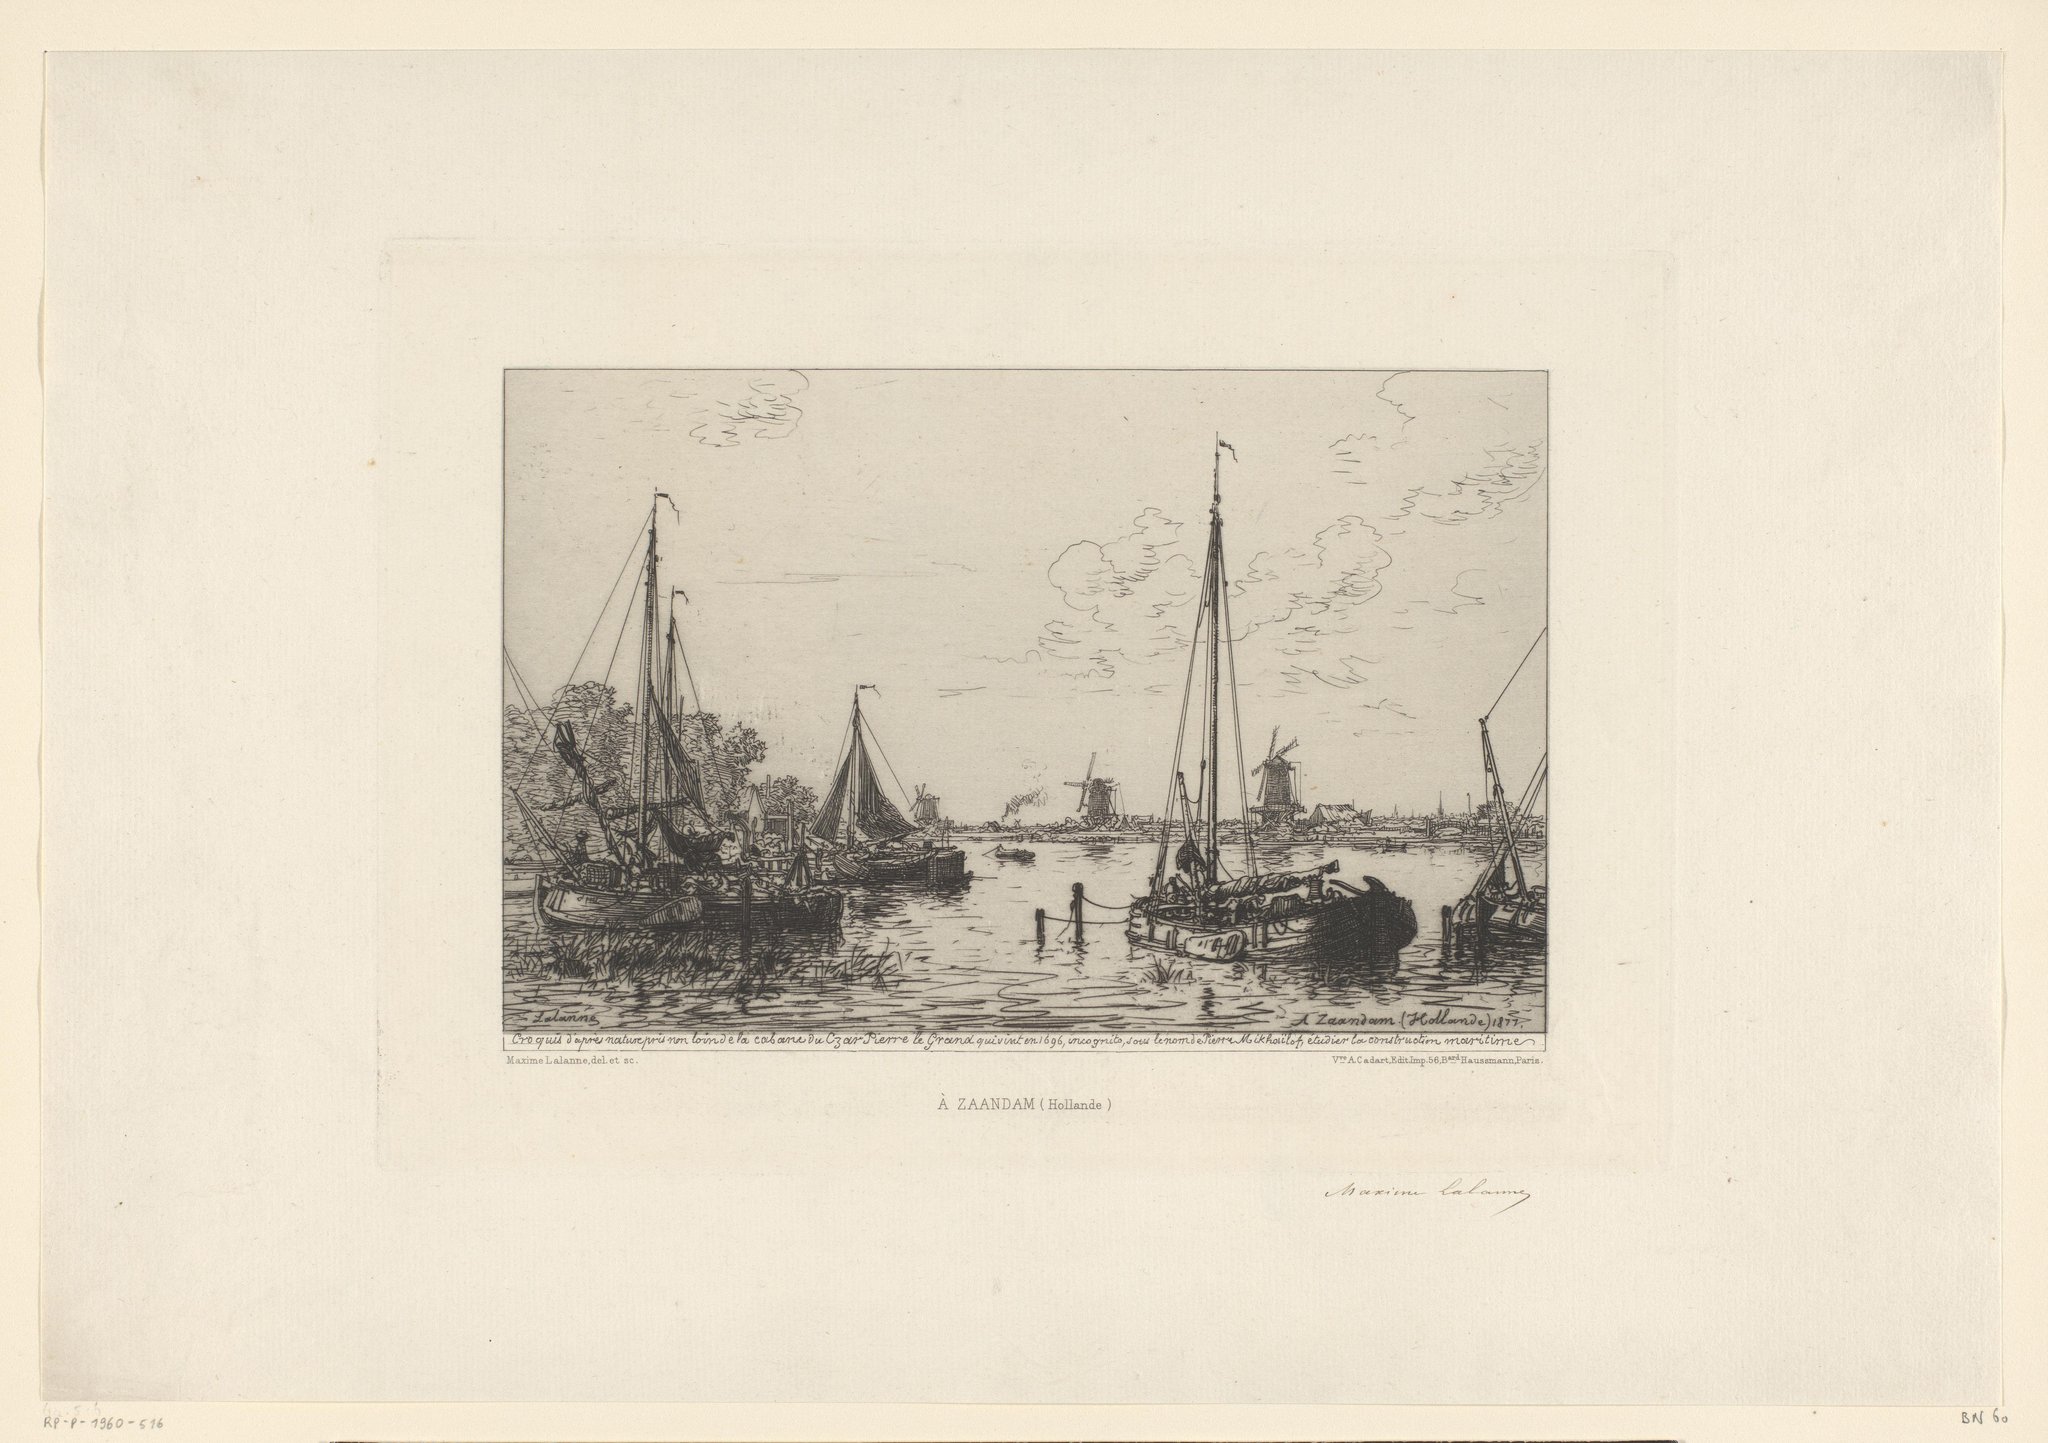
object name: print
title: Gezicht op Zaandam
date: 1877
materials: paper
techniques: drypoint, engraving, etching, intaglio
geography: france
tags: harbour, windmill in landscape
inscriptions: watermark, collector's mark: Lugt 2228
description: Gepubliceerd in: "L'Eau-forte en 1878", 1878.